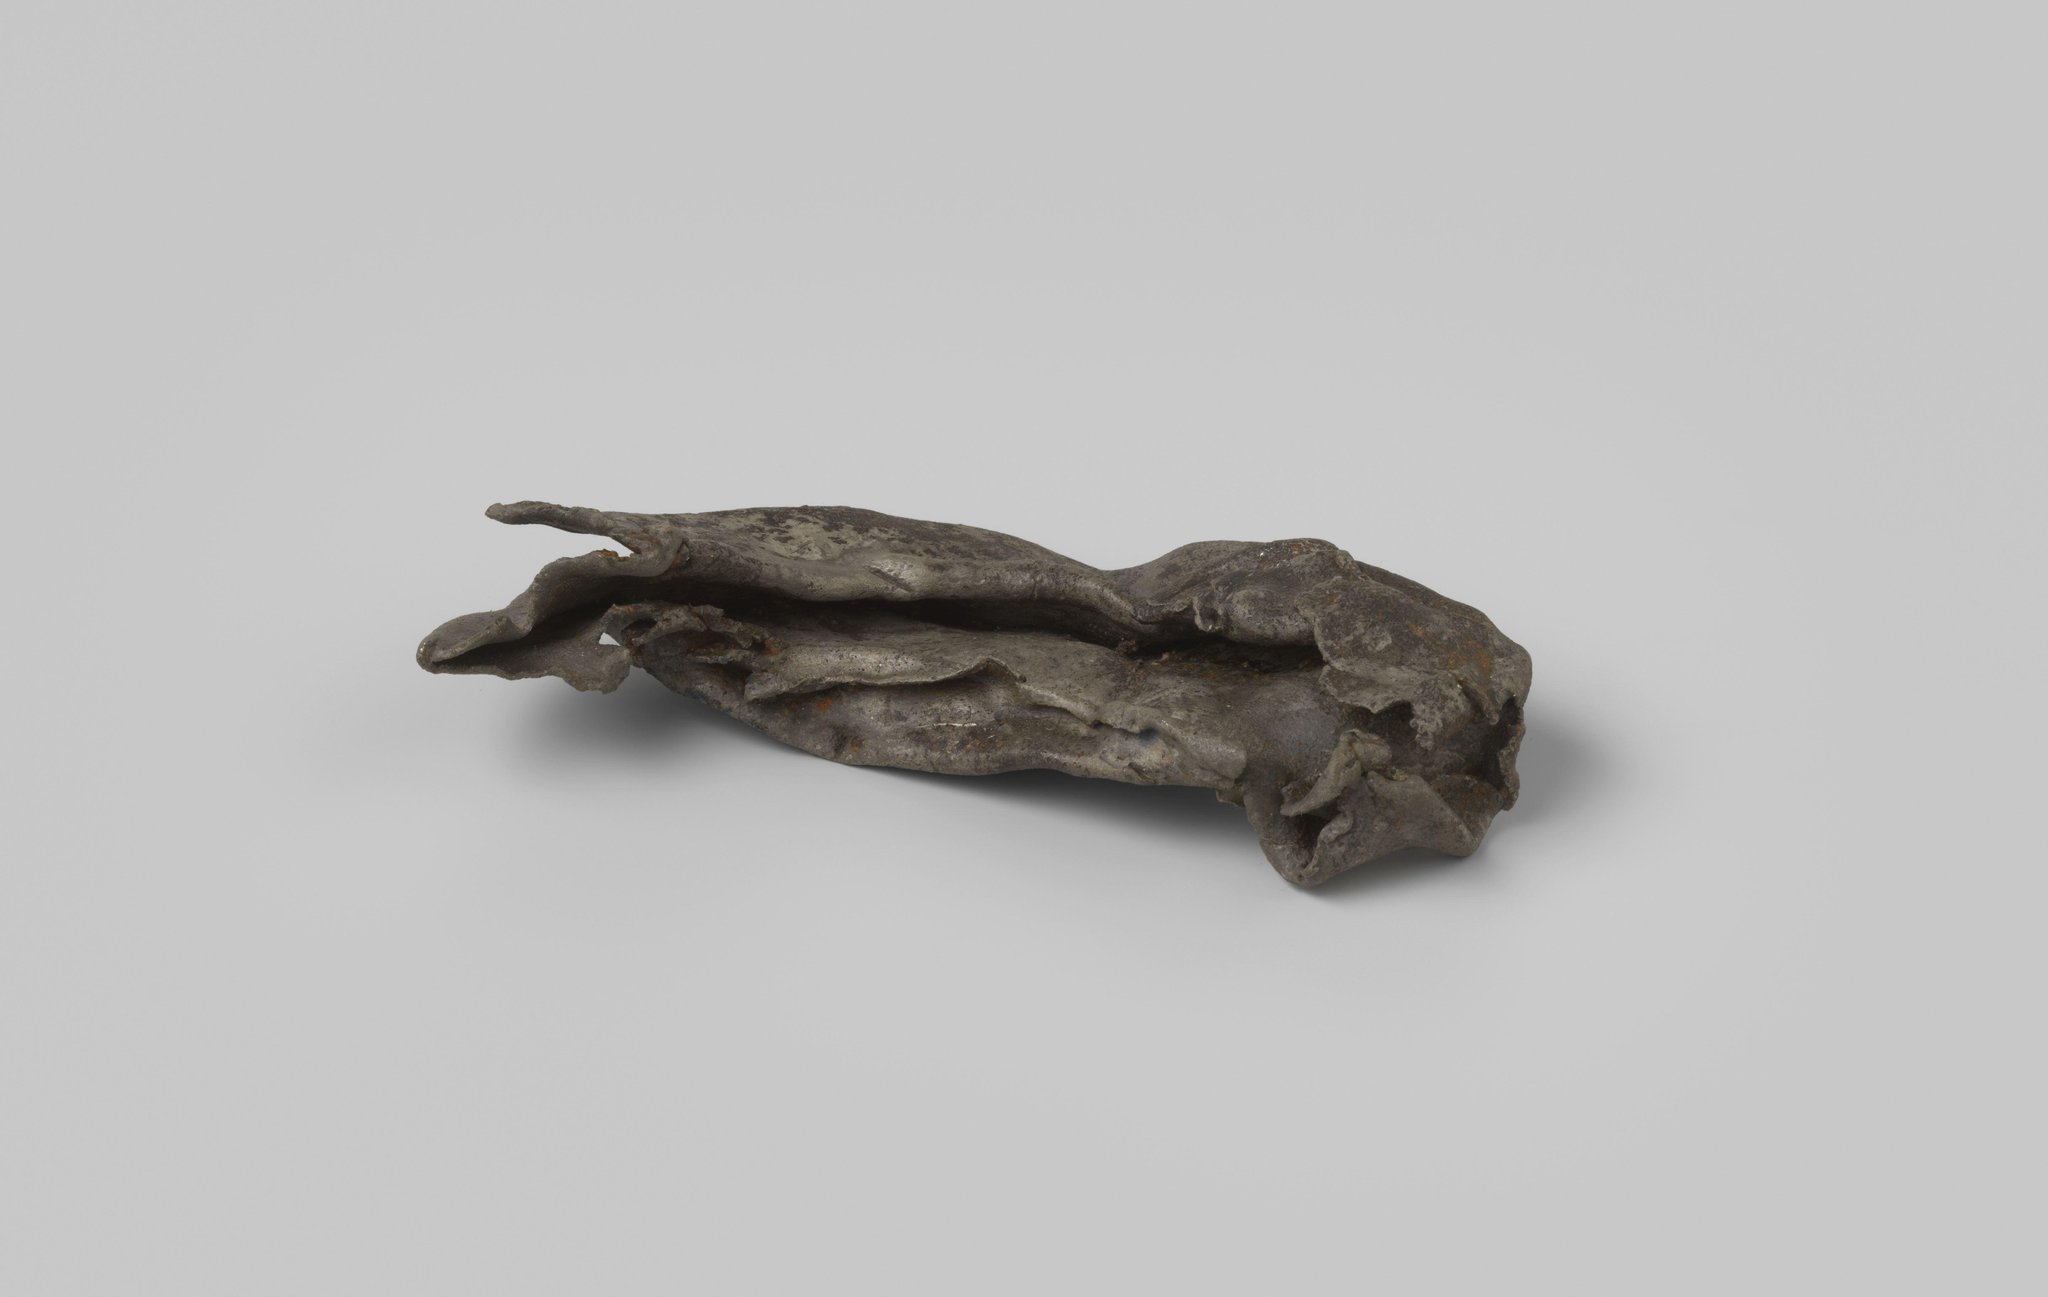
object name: chamber pot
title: Po uit het wrak van de Oost-Indiëvaarder Hollandia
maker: Anonymous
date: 1700-1743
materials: tin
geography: netherlands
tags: verenigde oostindische compagnie, hollandia (schip), annet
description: Container, chamber pot; fragm of rim and body, id. NG 1980-27H3210, squashed.